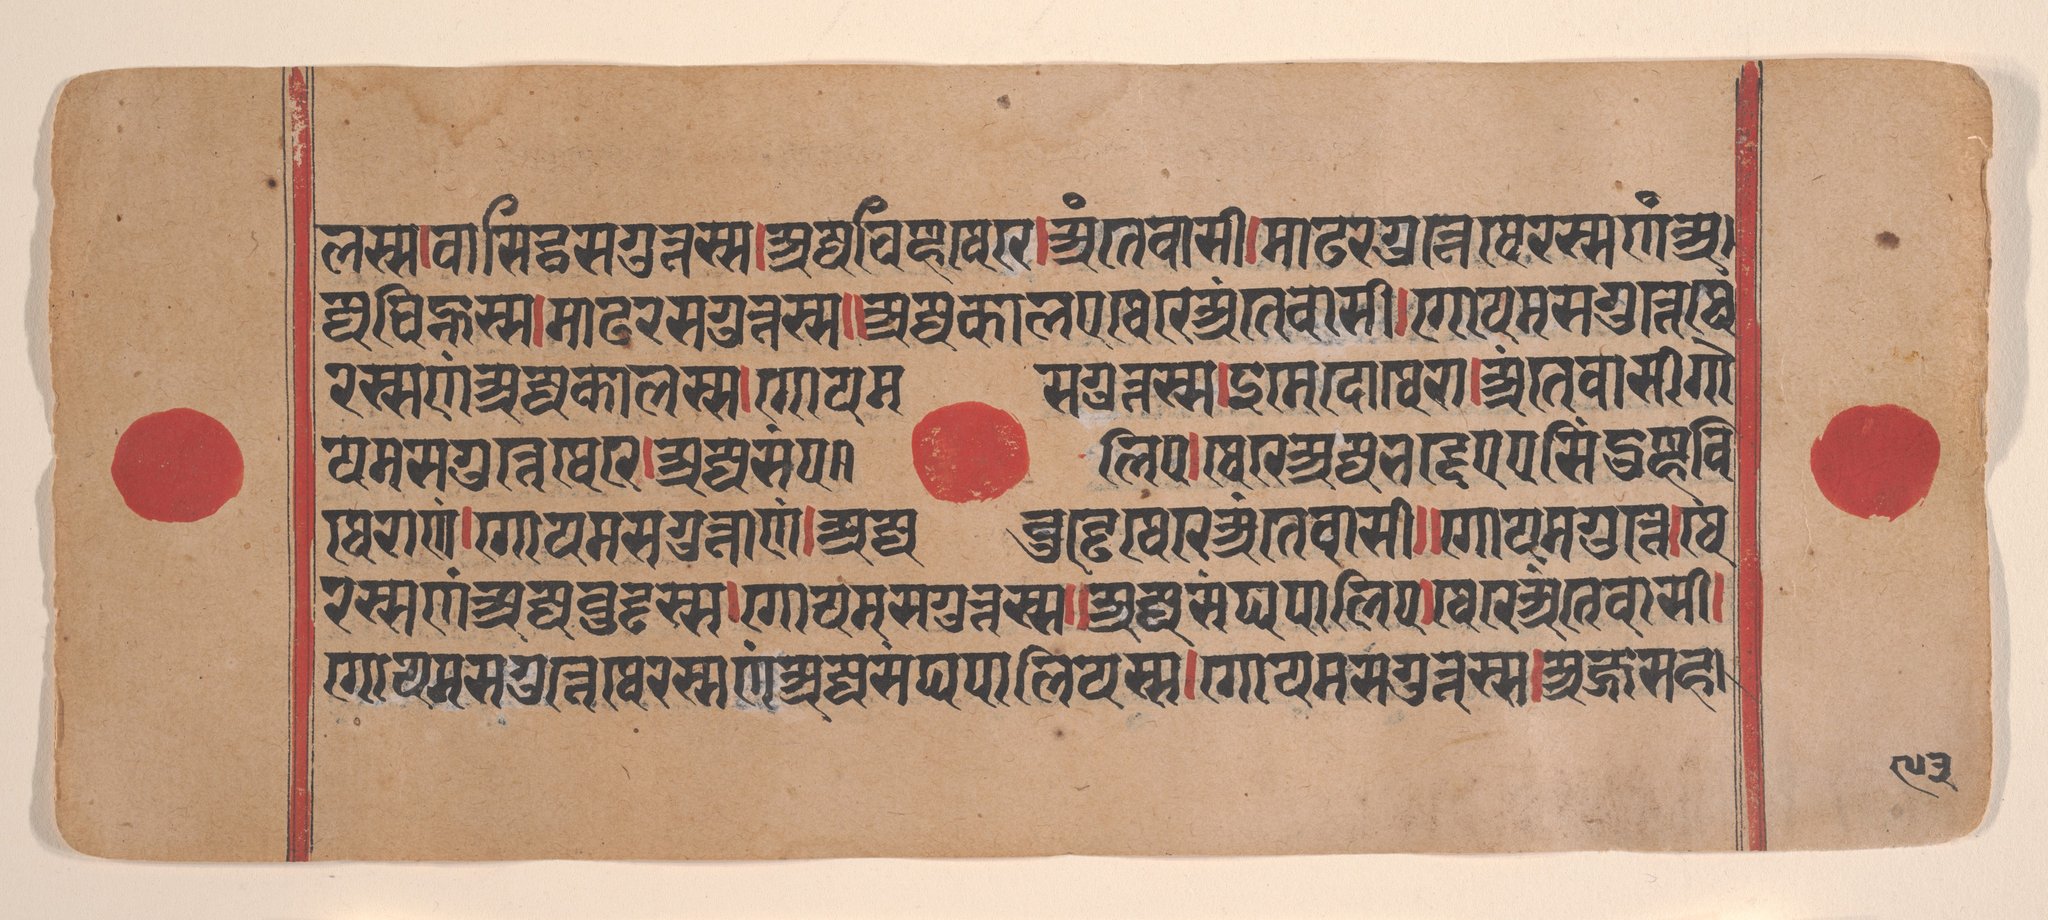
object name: folio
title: Page from a Dispersed Kalpa Sutra (Jain Book of Rituals)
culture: indian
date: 1401-1500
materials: gold, ink, paper, watercolor